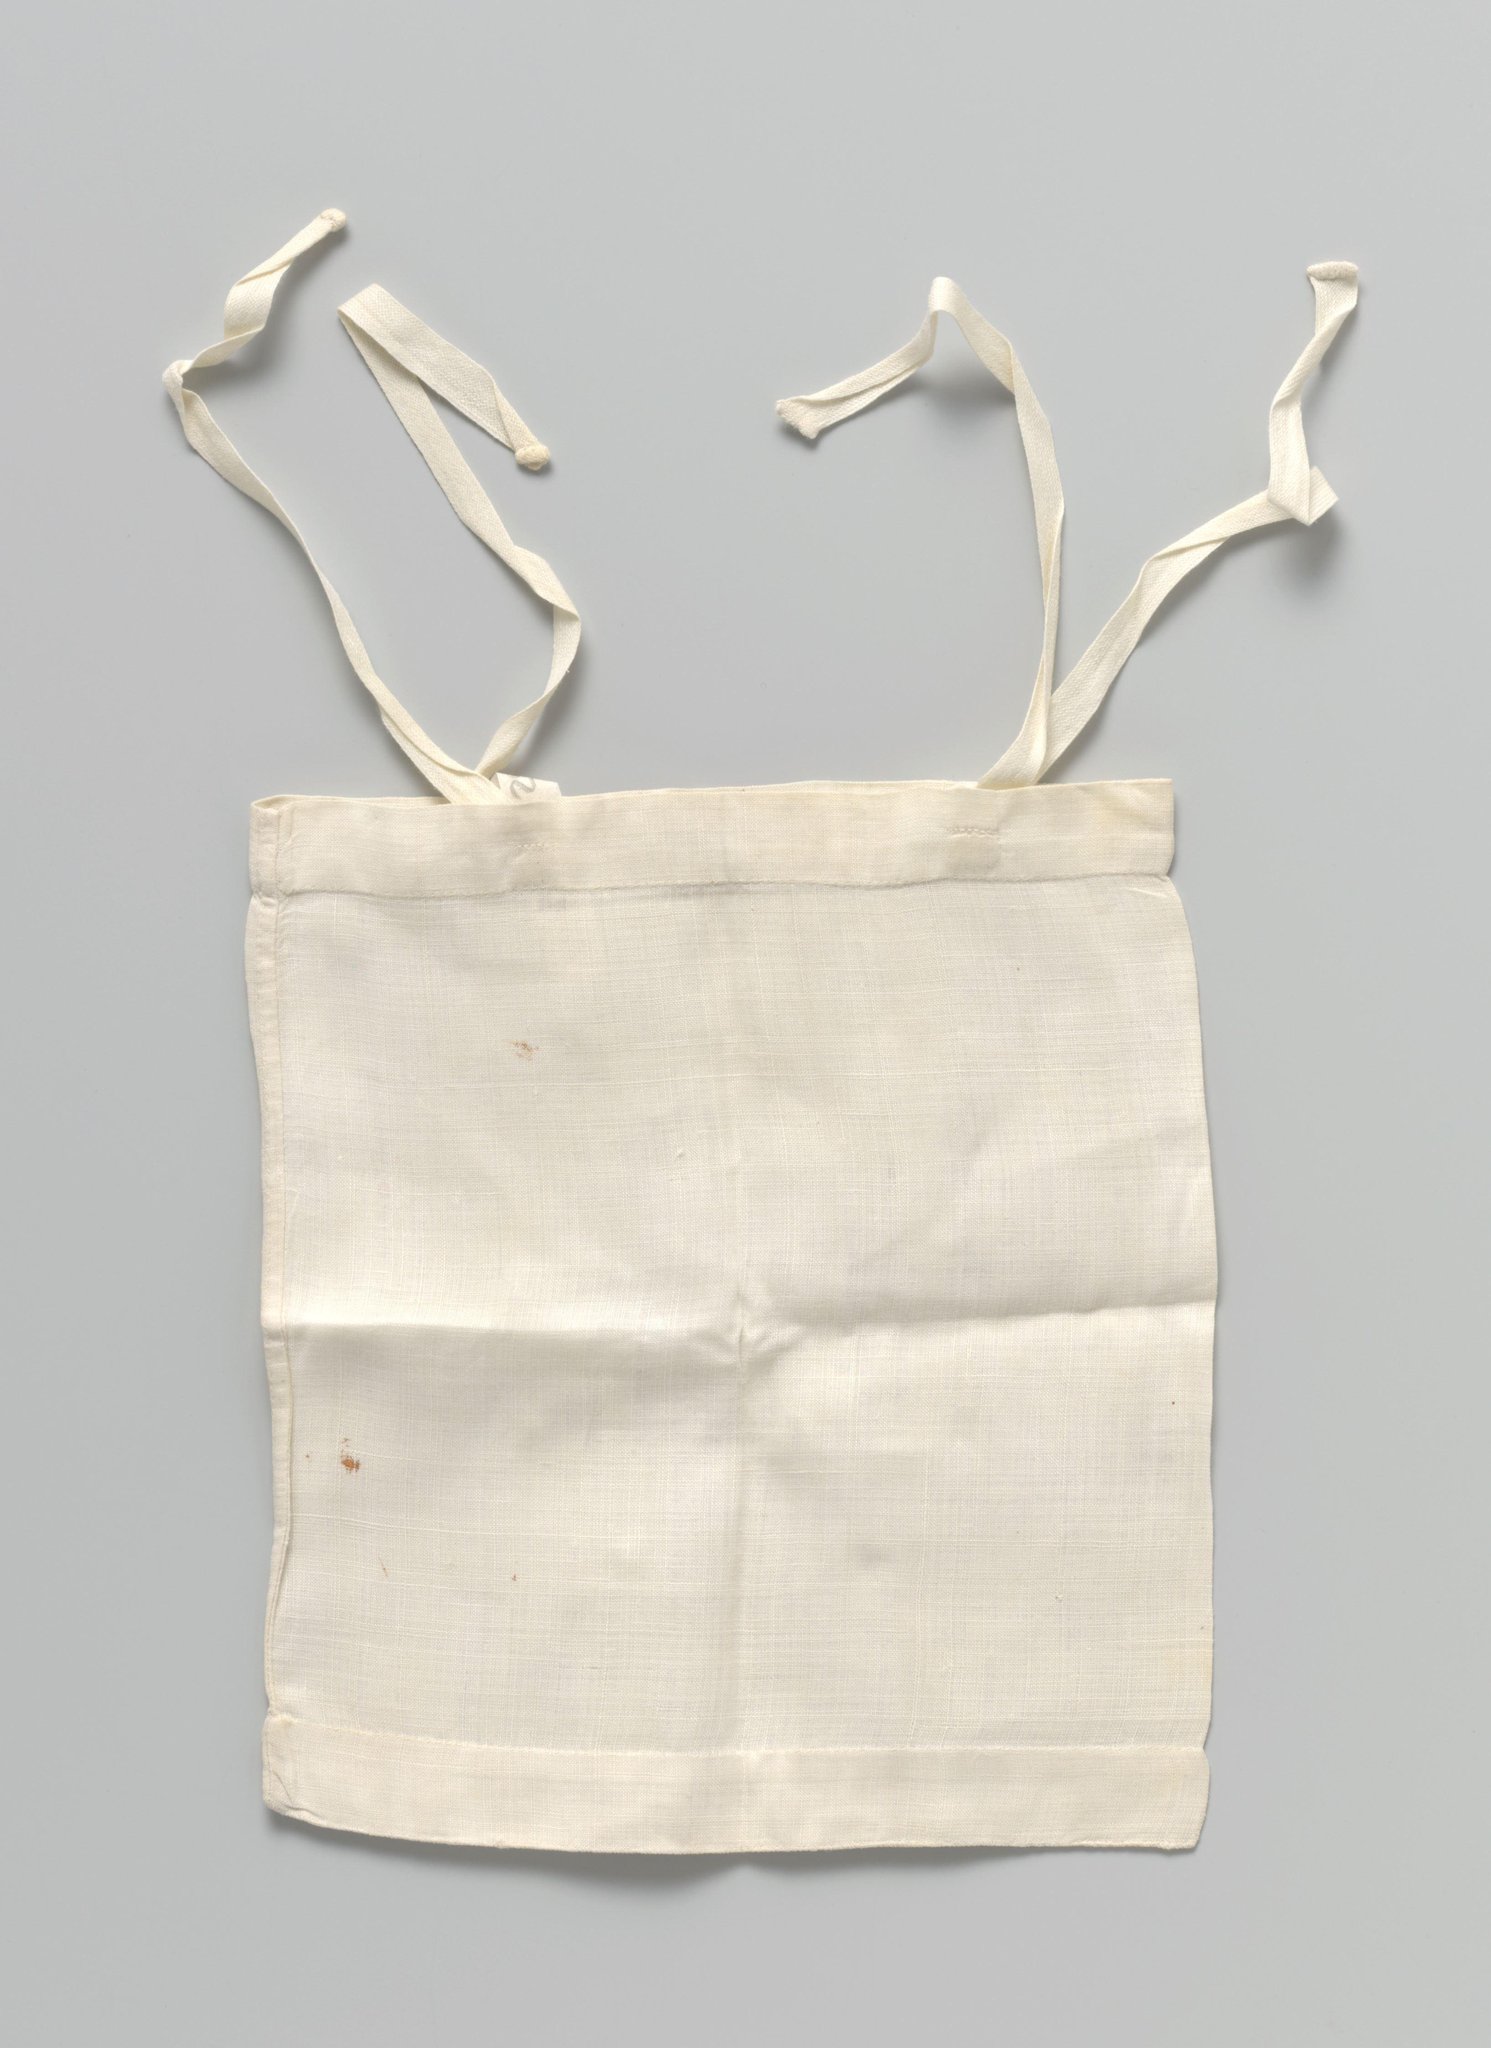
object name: pocket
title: Witte rokzak met vier linten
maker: Anonymous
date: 1850-1920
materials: textile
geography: europe